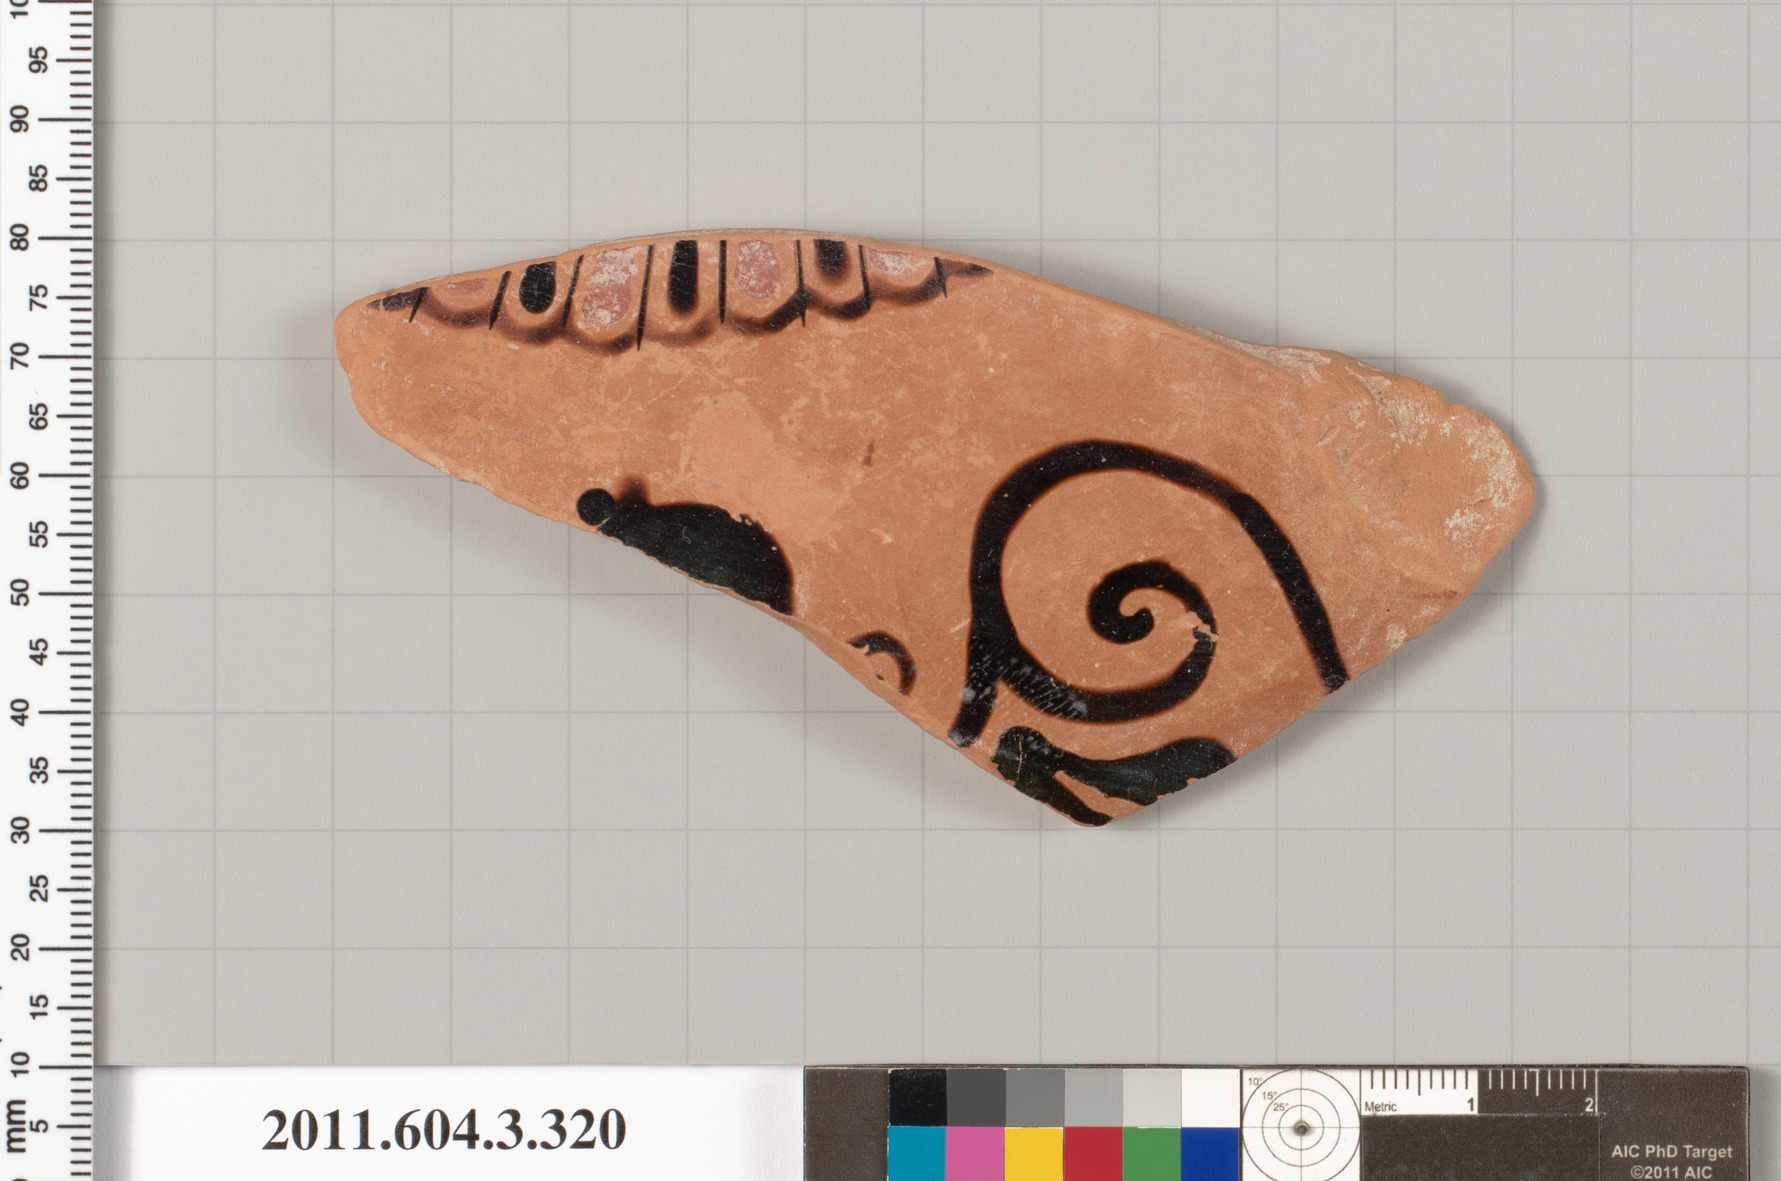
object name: neck amphora fragment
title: Terracotta fragment of a neck-amphora (jar)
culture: greek, attic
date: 525-501 BCE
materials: terracotta